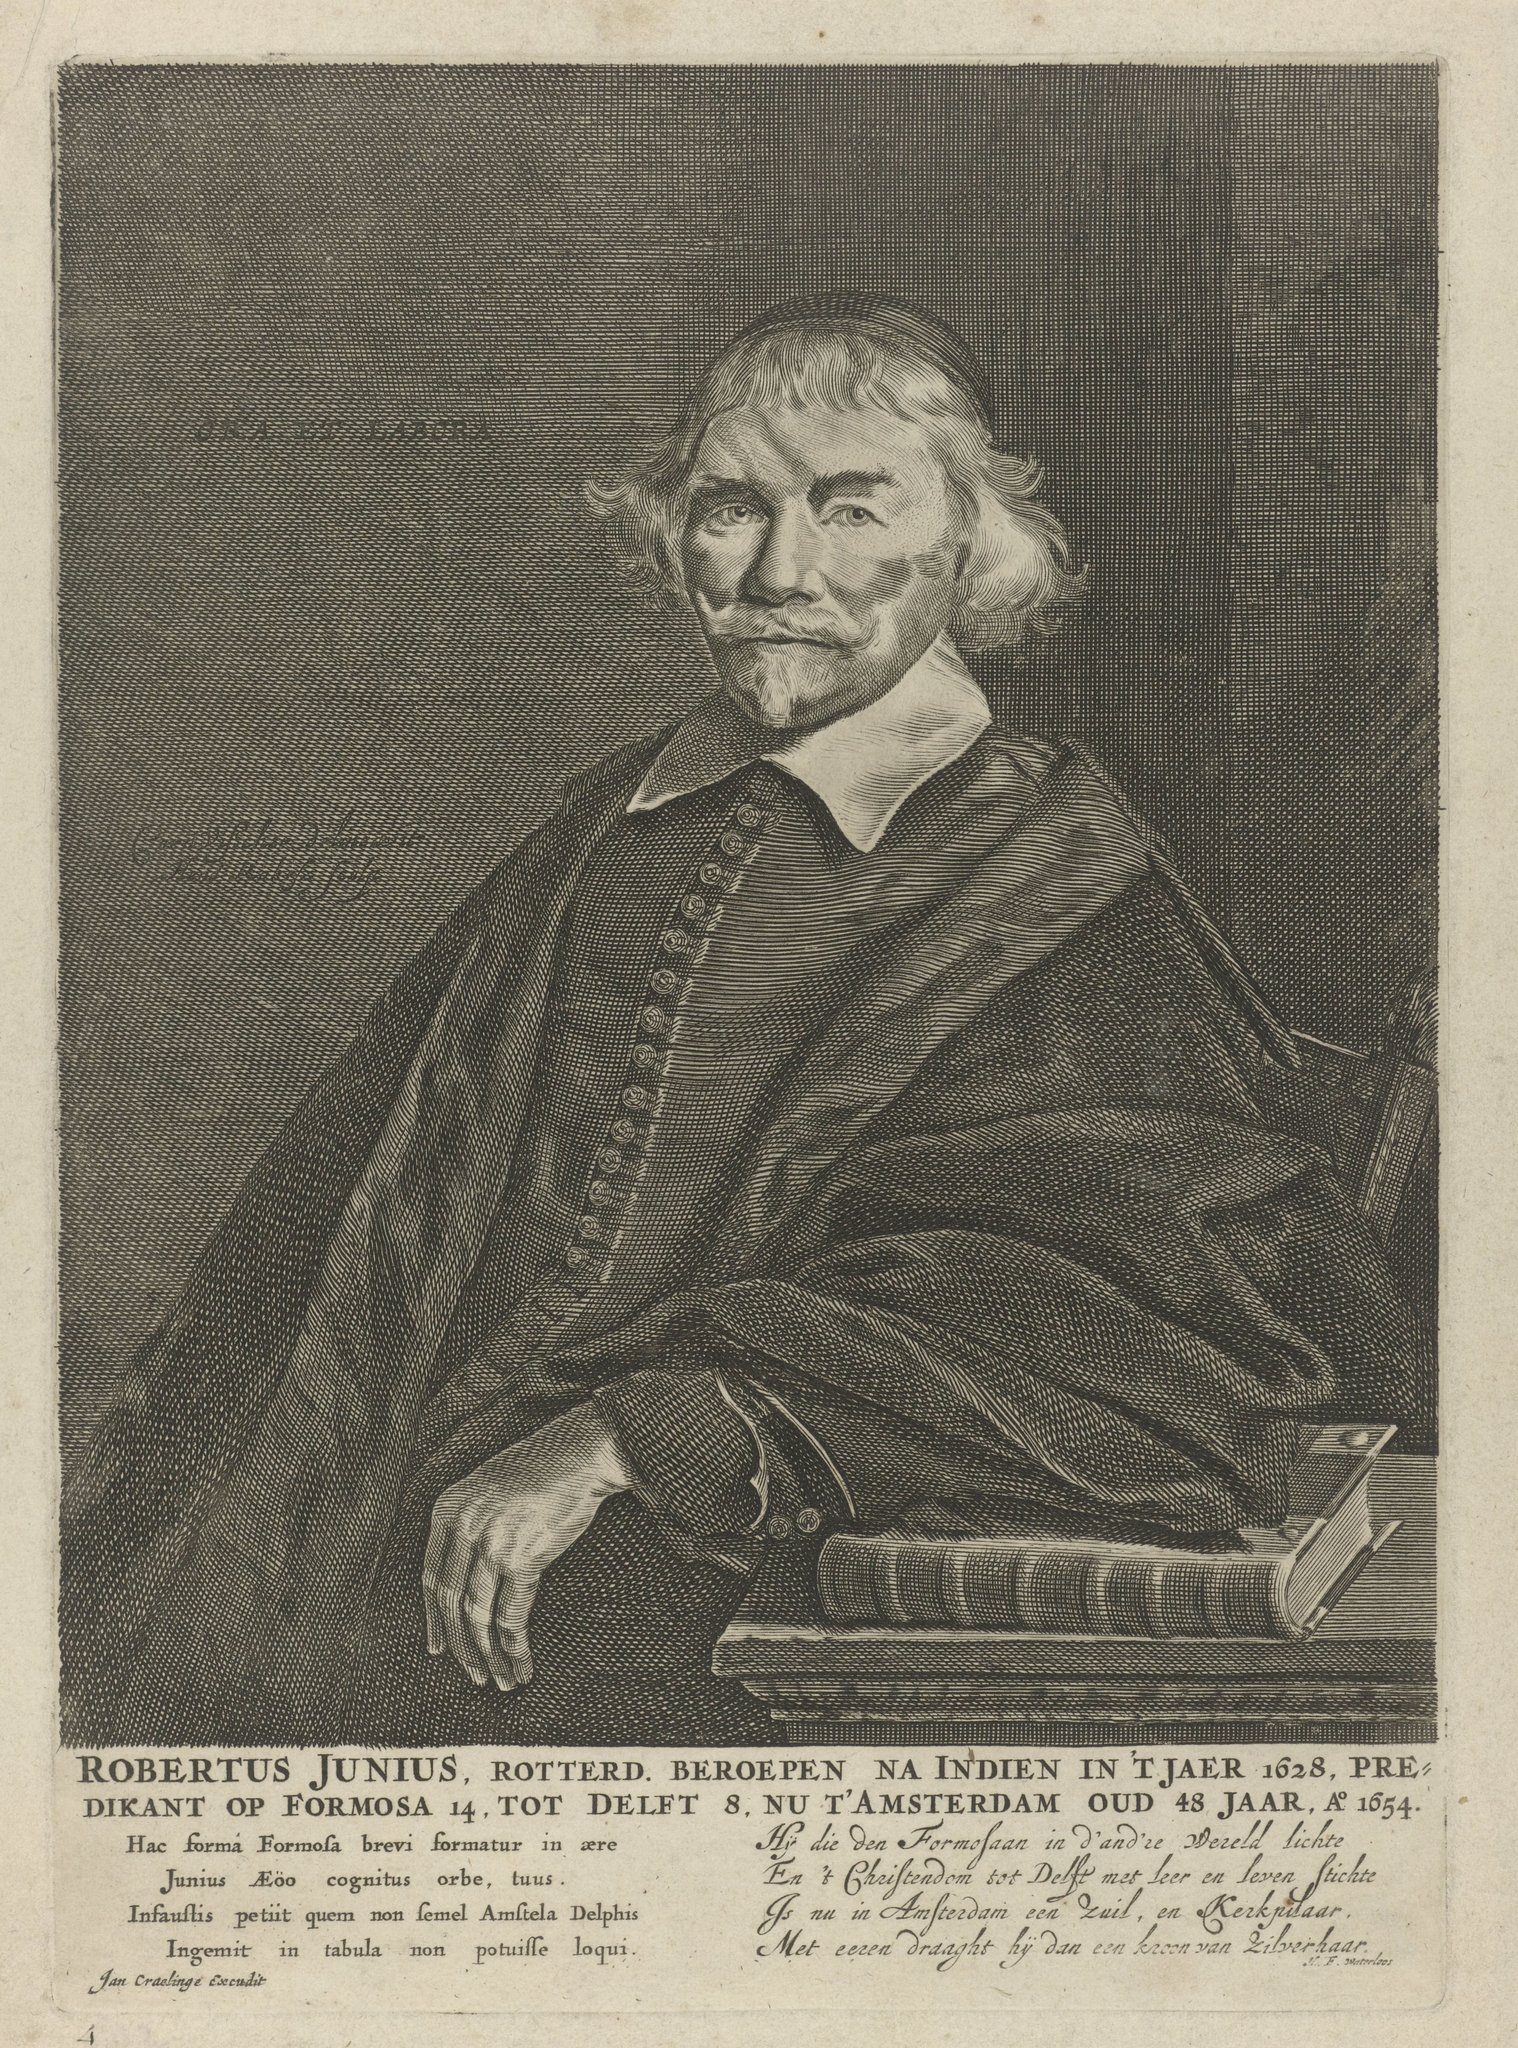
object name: print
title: Portret van Robert Junius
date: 1654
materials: paper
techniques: engraving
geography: amsterdam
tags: rotterdam, amsterdam, bible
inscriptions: collector's mark: Lugt 2228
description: Portret van de predikant Robert Junius op 48-jarige leeftijd. Links zijn zinspreuk 'Ora et Labora' (Bid en werk). Van 1629 tot 1643 verkondigde Junius het Evangelie op het eiland Formosa, het huidige Taiwan. Onder het portret zijn naam, titels en een vers in het Latijn en Nederlands.